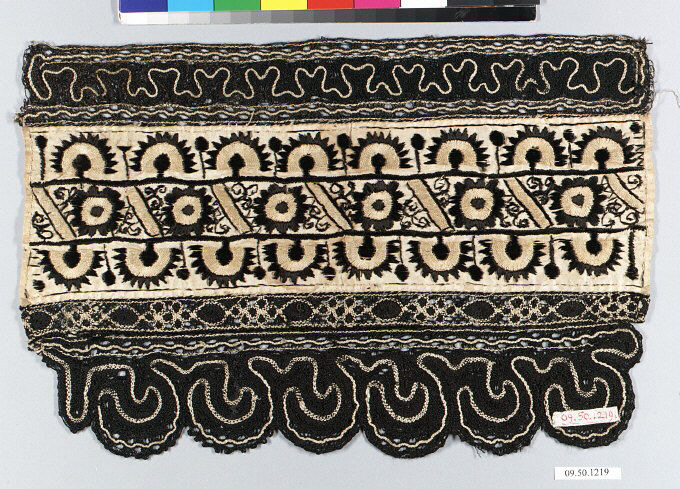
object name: headdress part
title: Detail from a headdress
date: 1801-1900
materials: thread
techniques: lace, embroidery